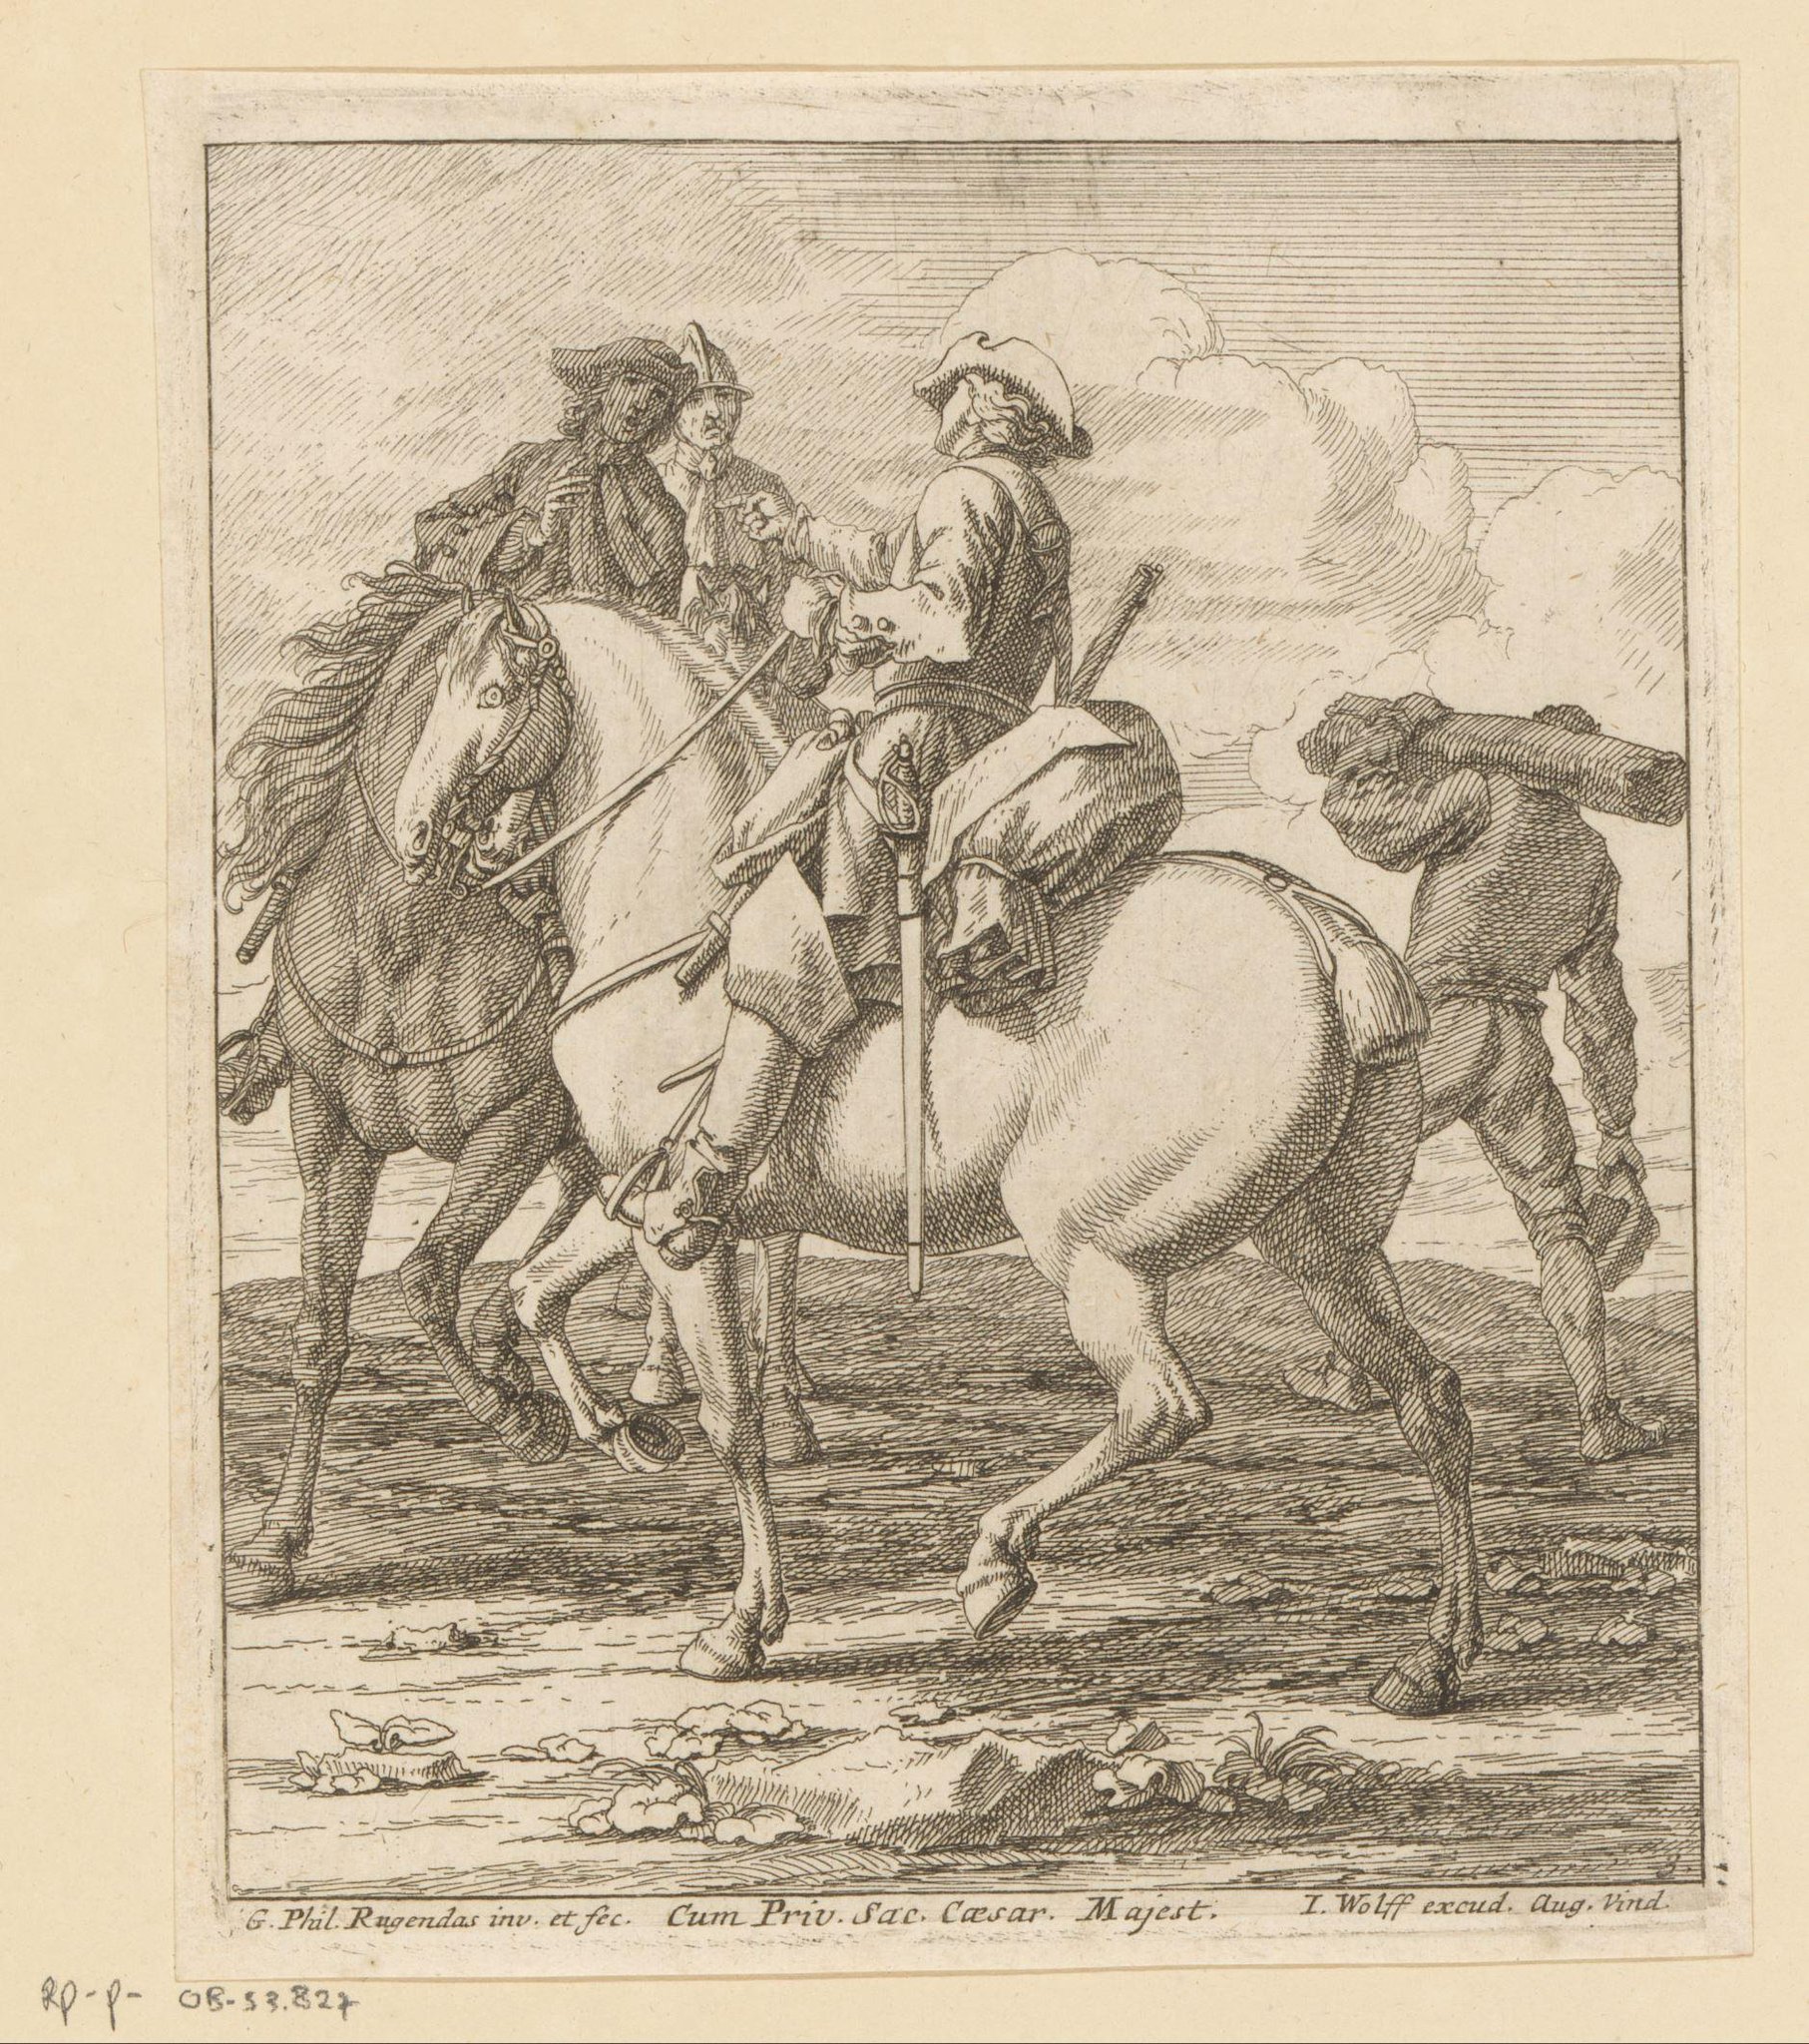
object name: print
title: Zes ruitergroepen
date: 1676-1742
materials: paper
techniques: etching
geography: augsburg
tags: riding a horse, ass, or mule; rider, horseman, armorial bearing, heraldry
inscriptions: collector's mark: Lugt 240